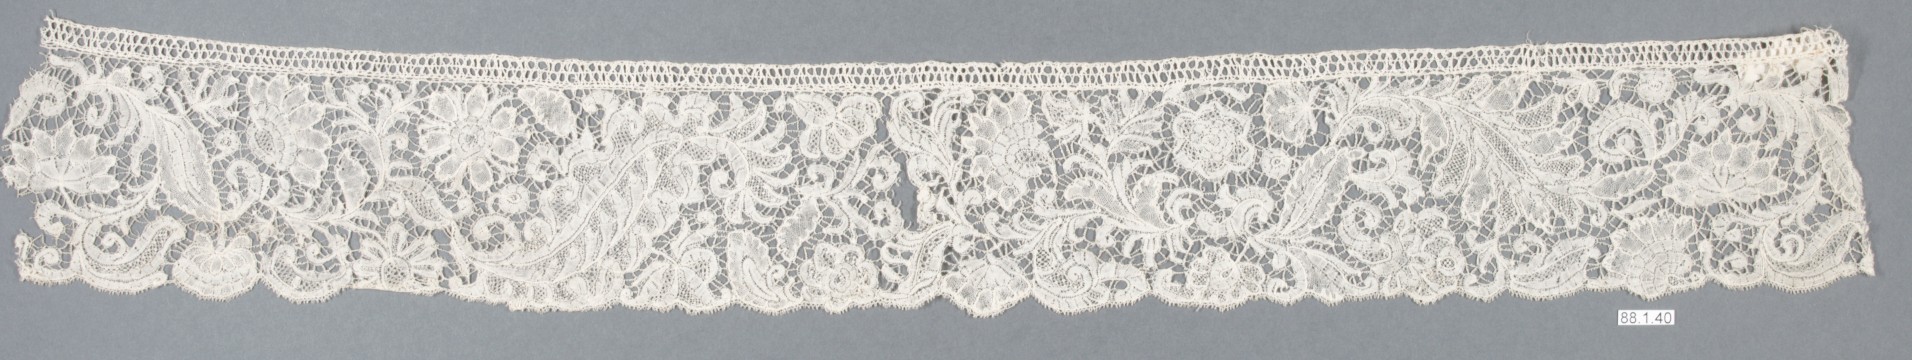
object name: piece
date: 1701-1800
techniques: lace